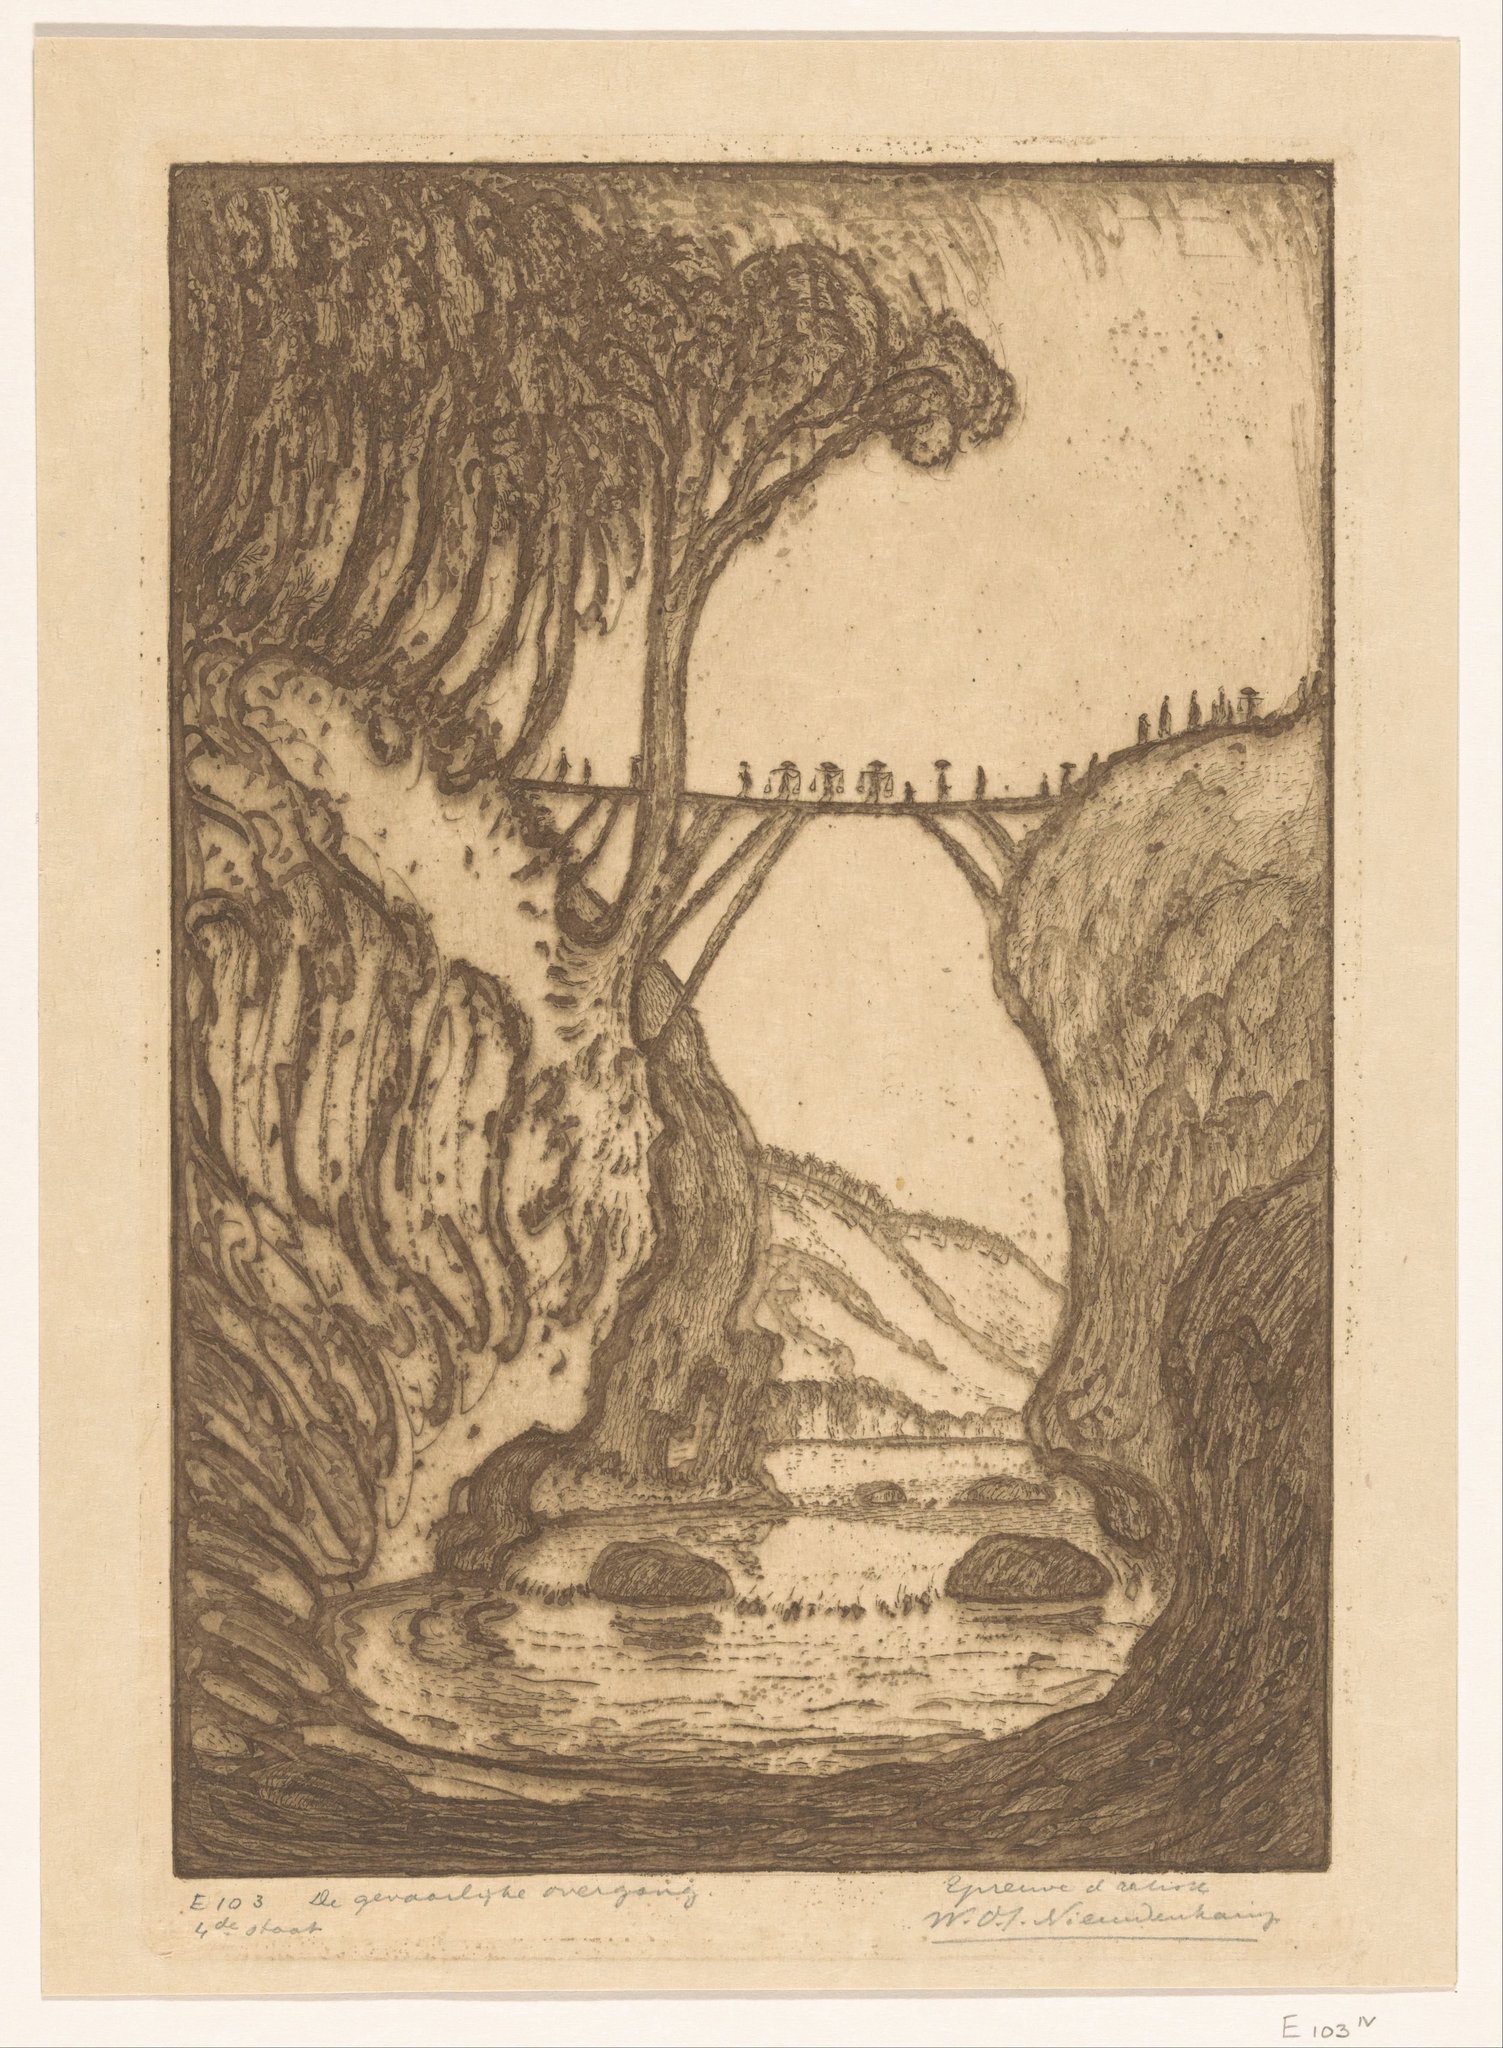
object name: print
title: Houten brug over een rivierkloof op Bali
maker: wijnand otto jan nieuwenkamp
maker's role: draughtsman, print maker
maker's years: 1874-1950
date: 1908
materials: paper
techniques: intaglio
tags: inland cliff face, bridge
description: Op de brug lopen figuren. Op verso een gedeelte van de ets 'Tempelwaarts, Madura' van Nieuwenkamp.